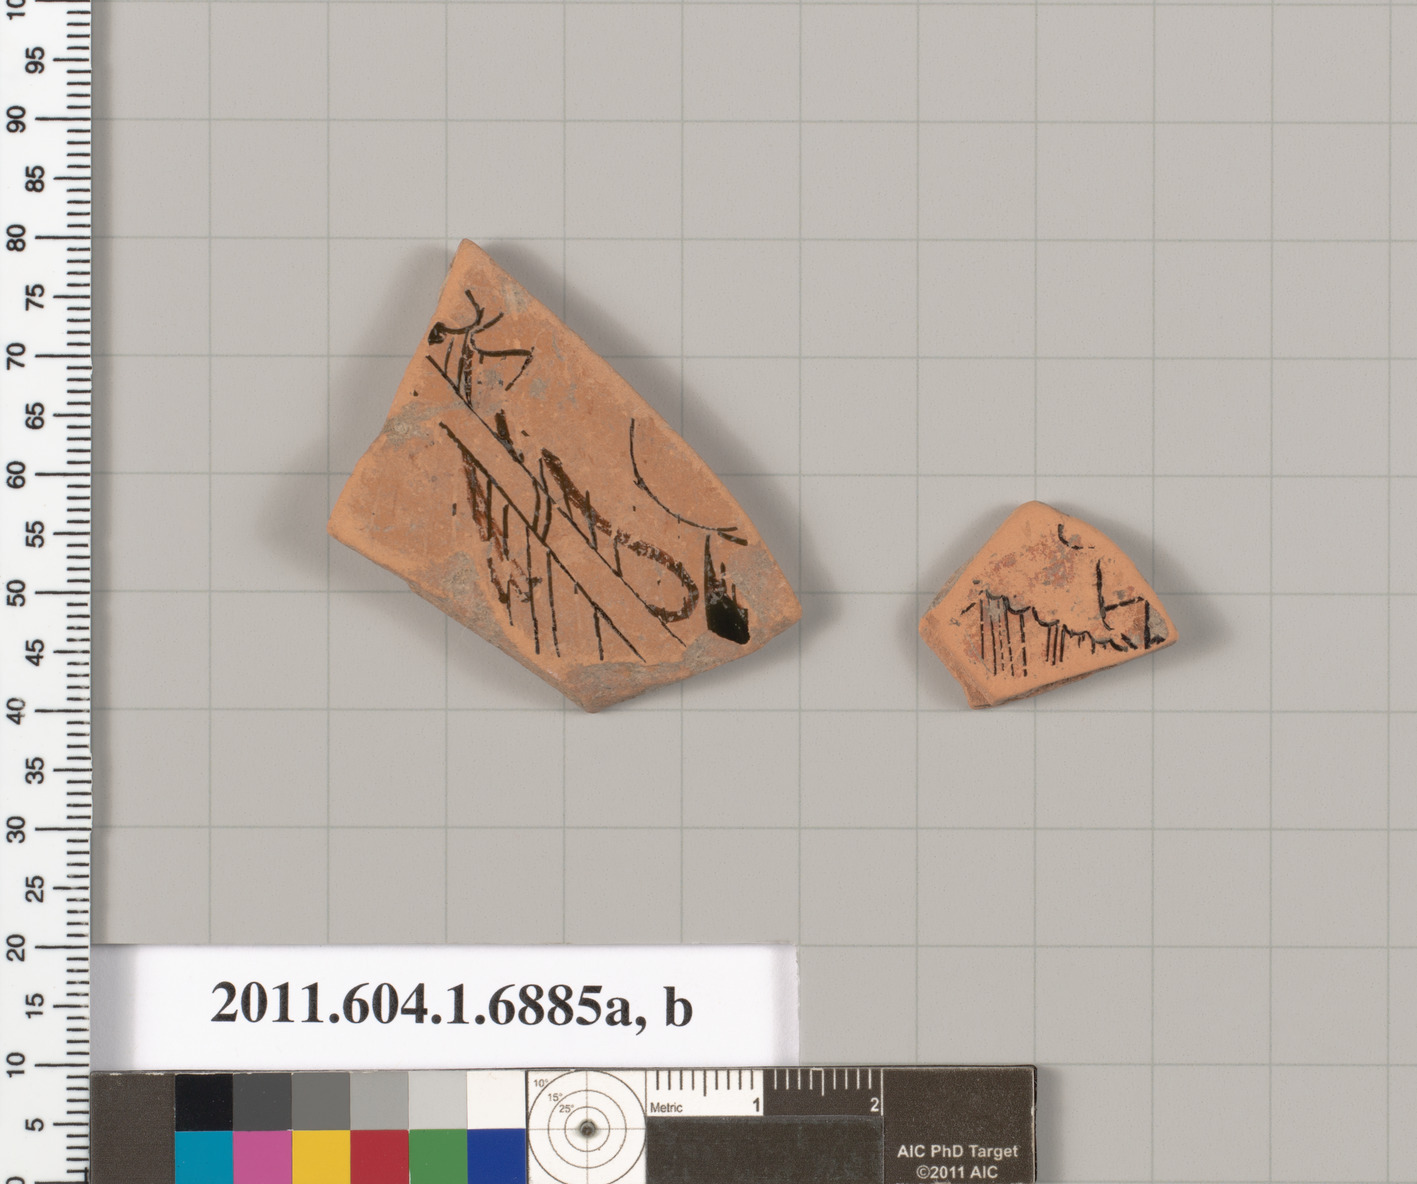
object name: kylix fragment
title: Terracotta fragments of a kylix (drinking cup)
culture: greek, attic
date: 490-470 BCE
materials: terracotta